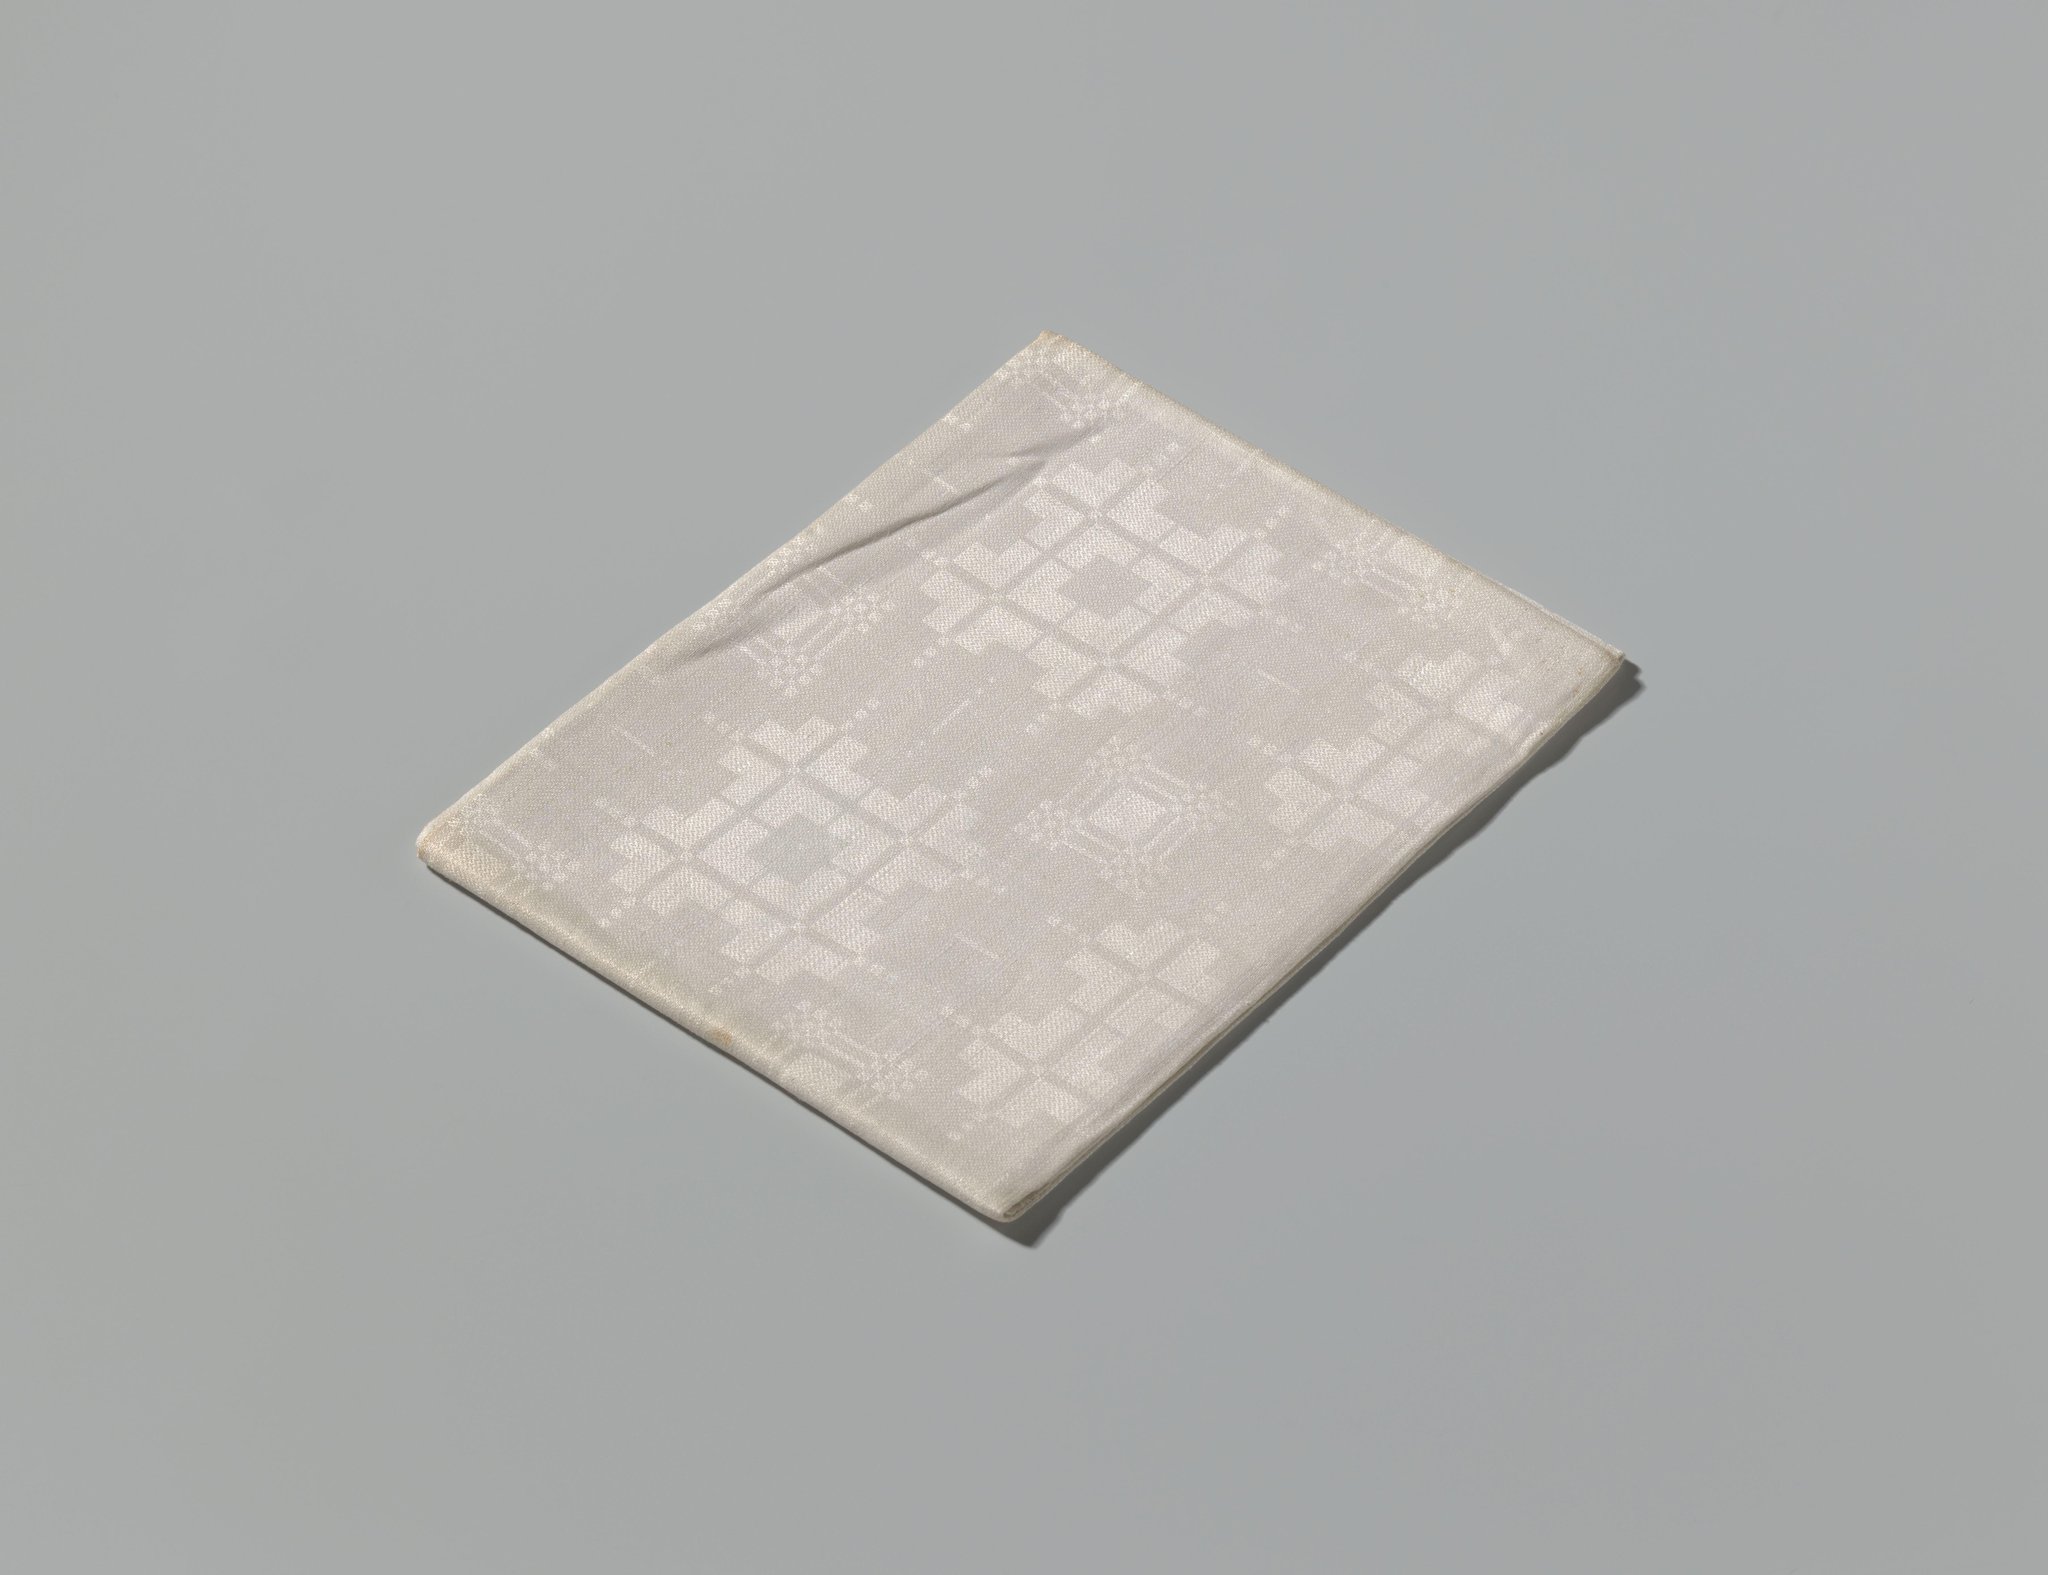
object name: napkin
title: Servet van linnen met pellenpatroon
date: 1400-1950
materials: linen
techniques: peeled fabric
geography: northern netherlands